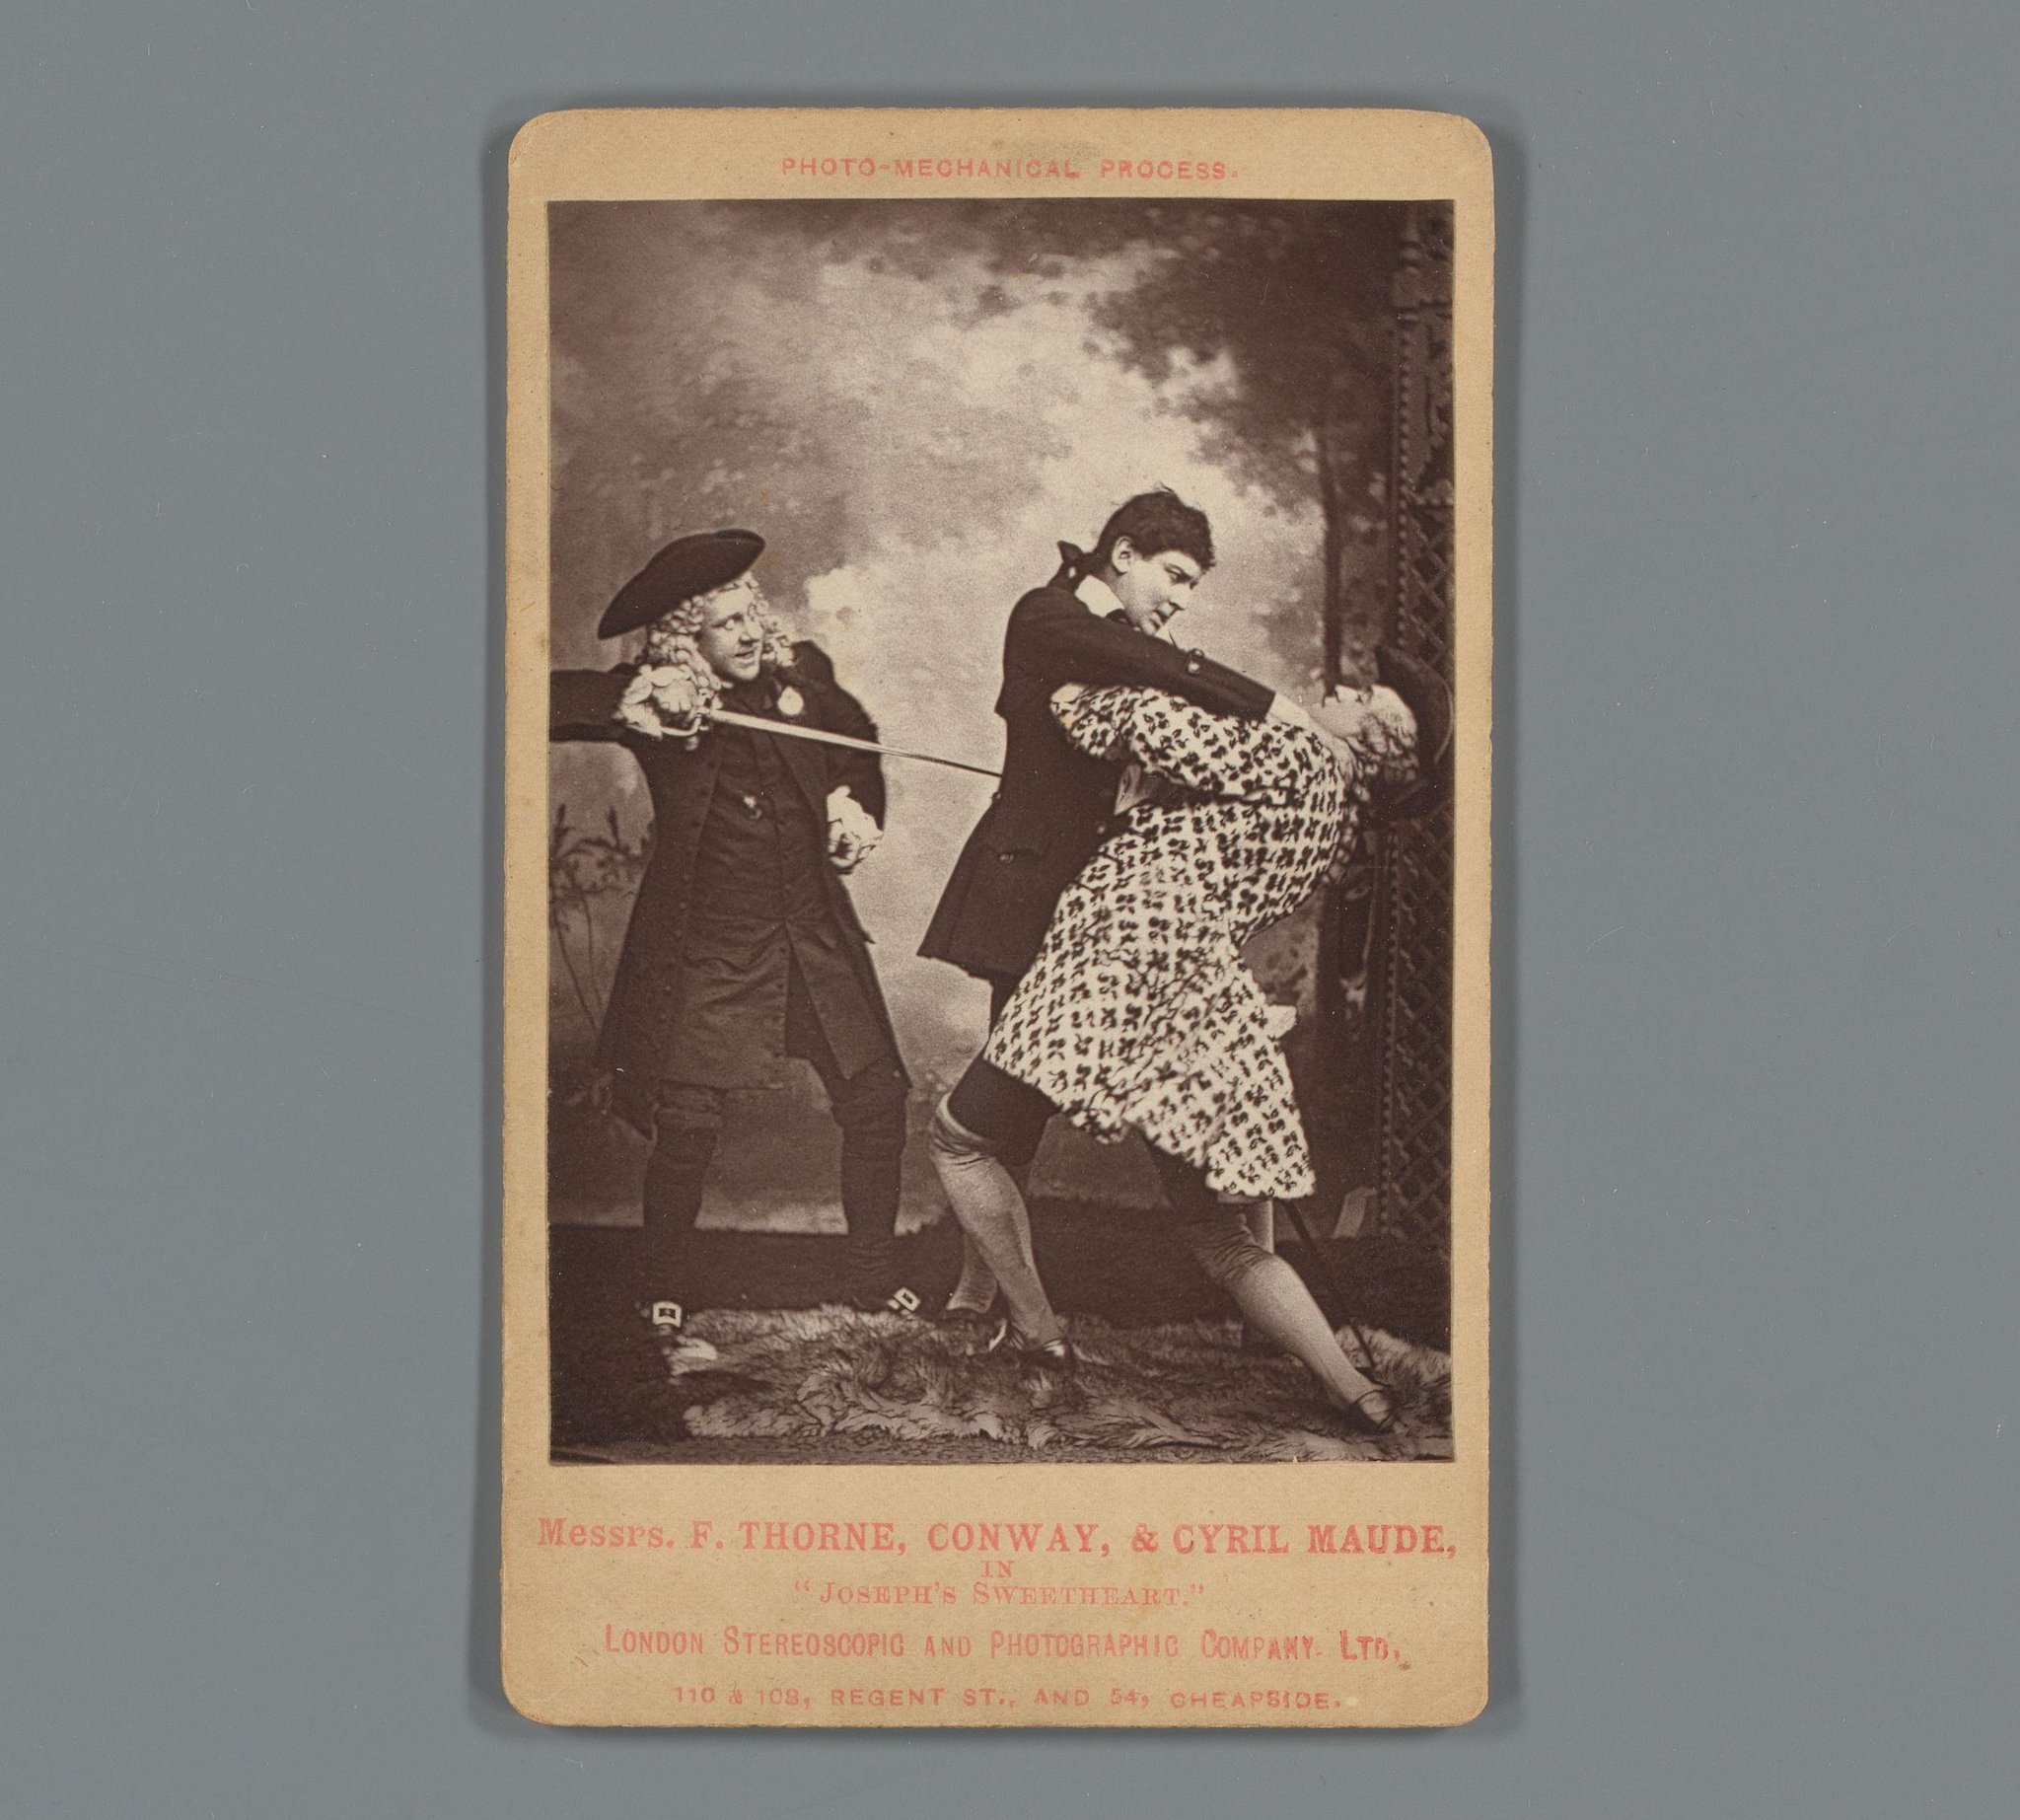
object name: carte de visite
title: Portret van Fred Thorne, Harry Conway en Cyril Maude als reclame voor de voorstelling 'Joseph's Sweetheart' in het Vaudeville Theatre, Londen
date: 1870-1900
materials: cardboard, photographic support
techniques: woodburytype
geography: london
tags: london, advertising, stage costume, historical persons, portrait of actor, actress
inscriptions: inscription: ‘PHOTO-MECHANICAL PROCESS./ London Stereoscopic & Photographic., Ltd./ 106 & 108, REGENT ST., AND 54, CHEAPSIDE.’, inscription: ‘VAUDEVILLE THEATRE./ Sole Lessee and Manager - Mr. THOMAS THORNE./ Every Evening at 8 o'clock, Joseph's Sweetheart,/ By ROBERT BUCHANAN./ (...)/ Acting Manager - Mr. SYDNEY ALPORT.’